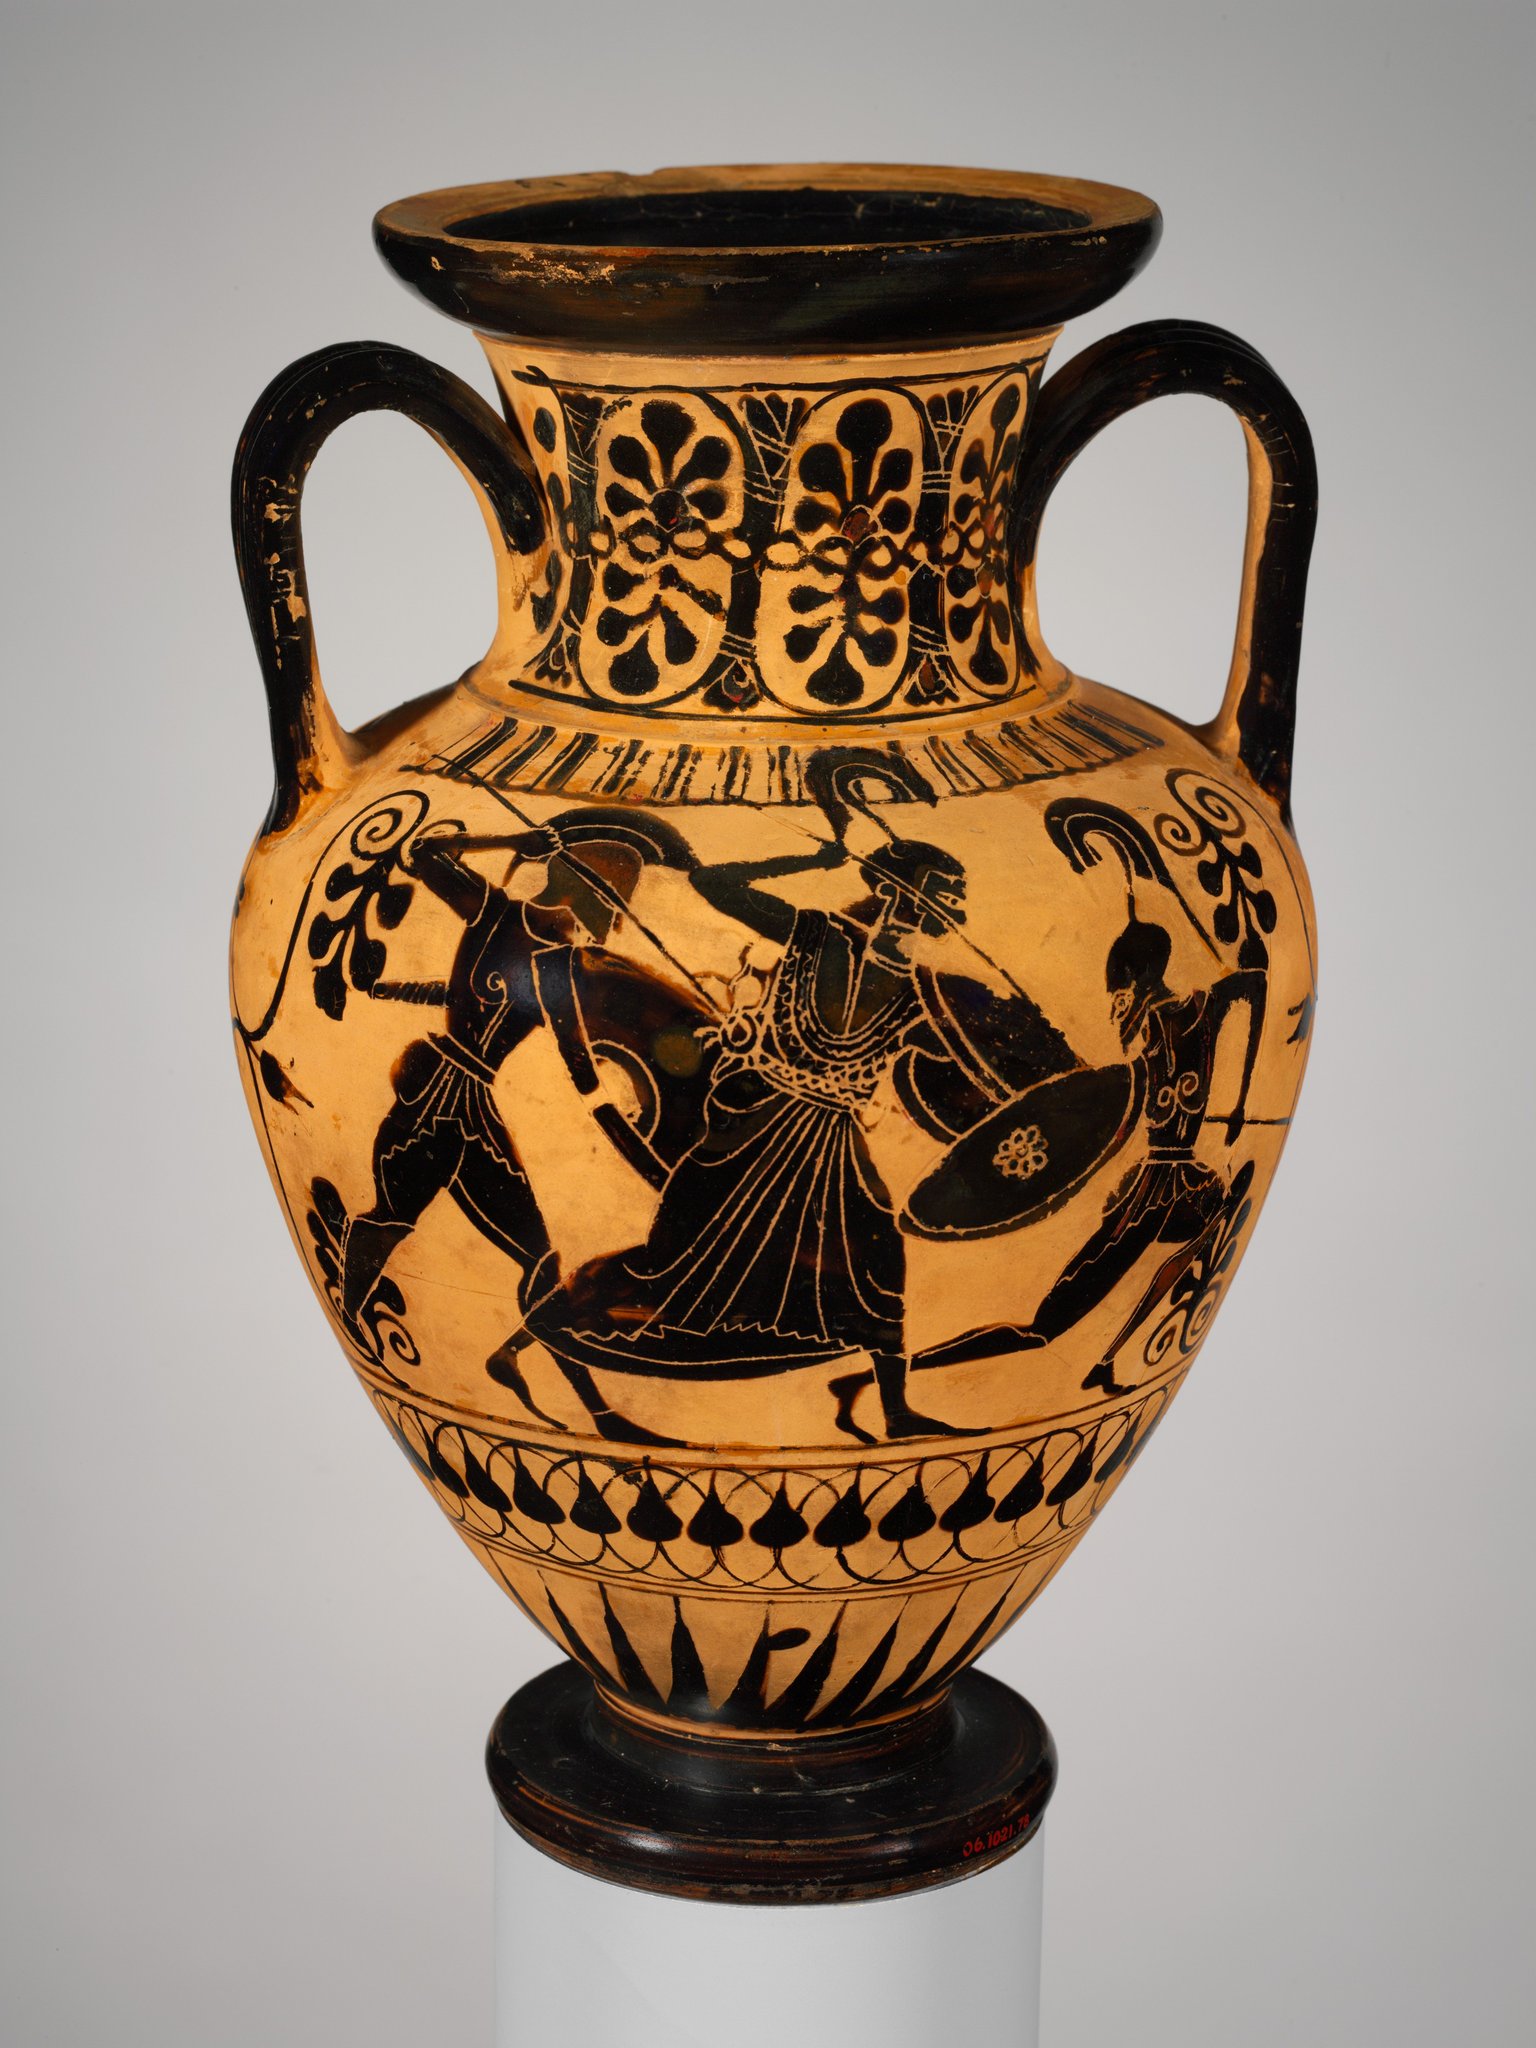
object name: neck amphora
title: Terracotta neck-amphora (jar)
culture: greek, attic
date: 525-500 BCE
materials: terracotta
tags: battles,athena,hermes,herakles